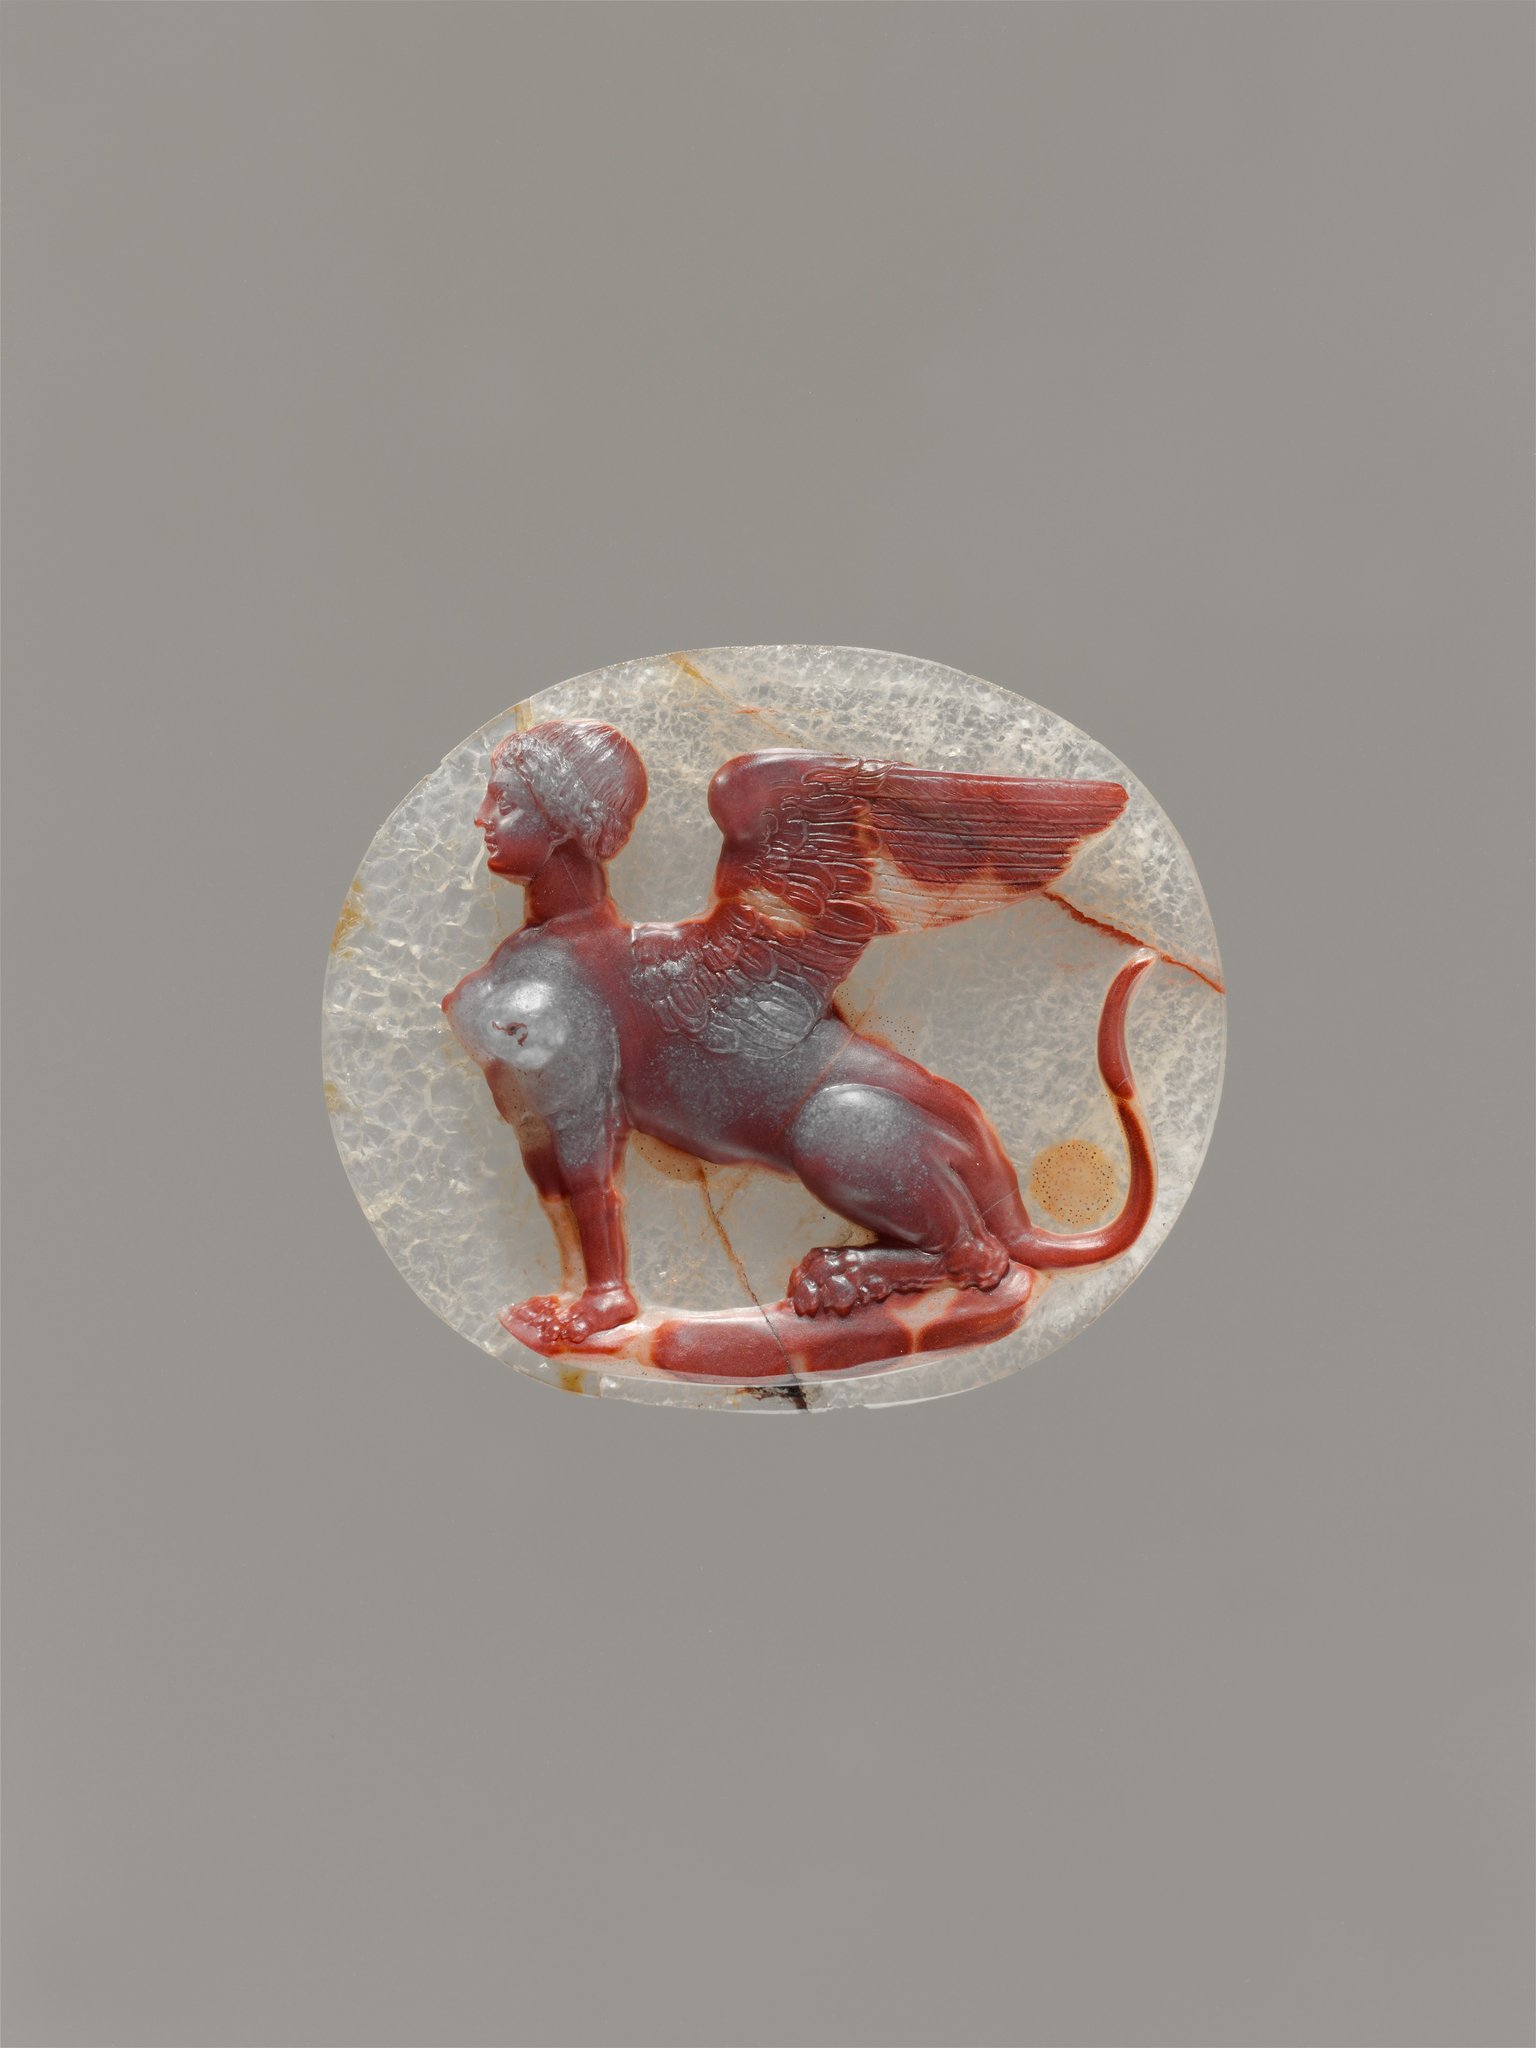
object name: cameo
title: Sphinx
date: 1701-1800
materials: jasper, quartz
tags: heads,medusa,sphinx